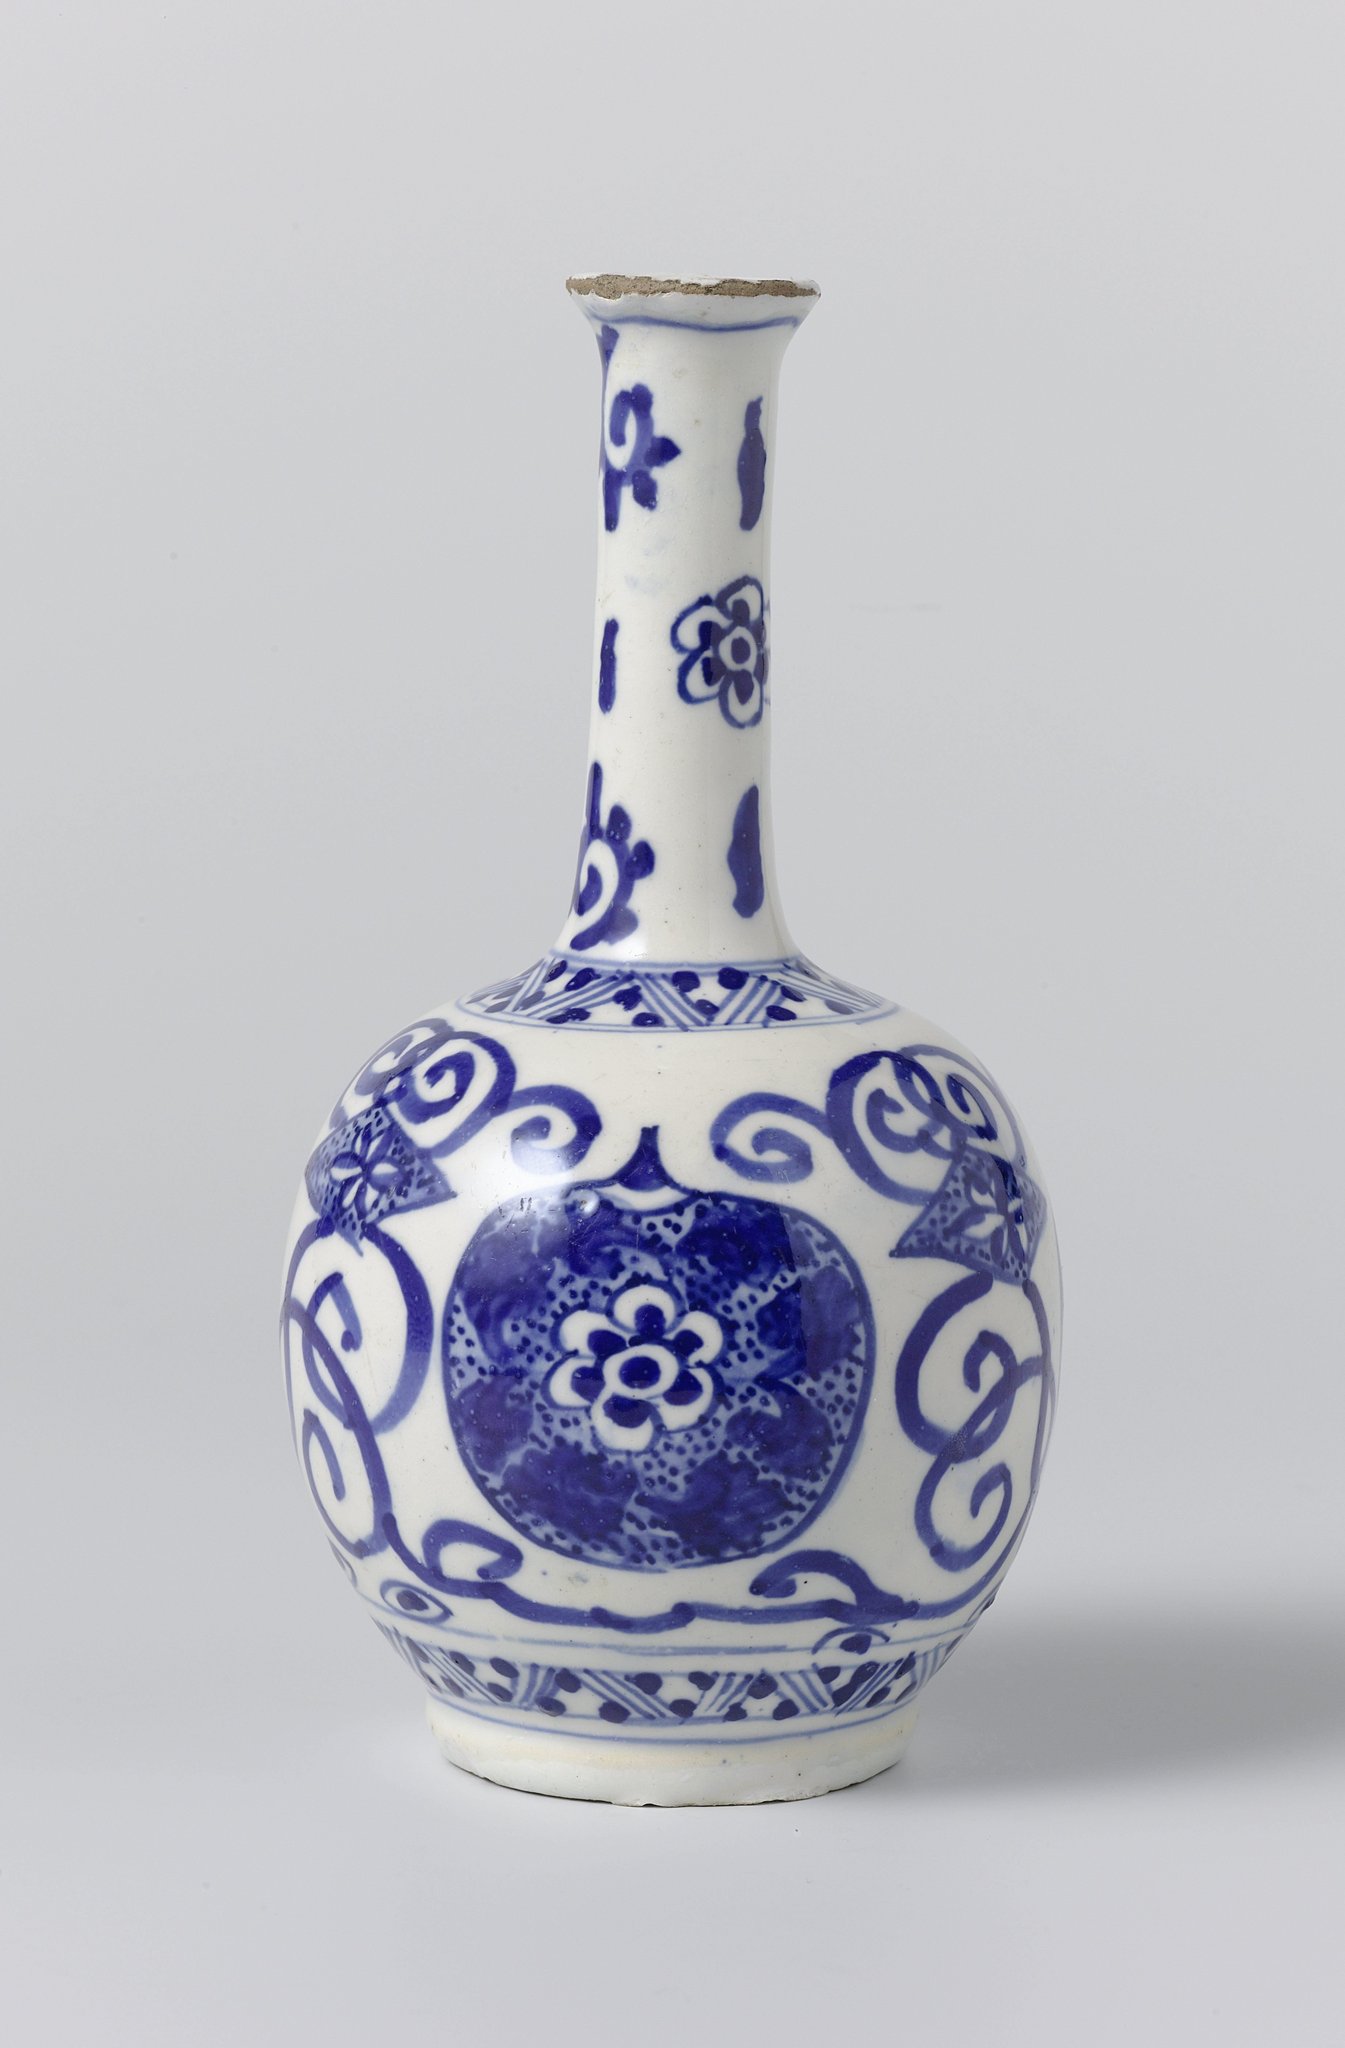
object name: vase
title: Vaas van faience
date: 1690-1710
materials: faience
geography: delft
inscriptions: mark: ‘[..]AW(ineen)/ j’